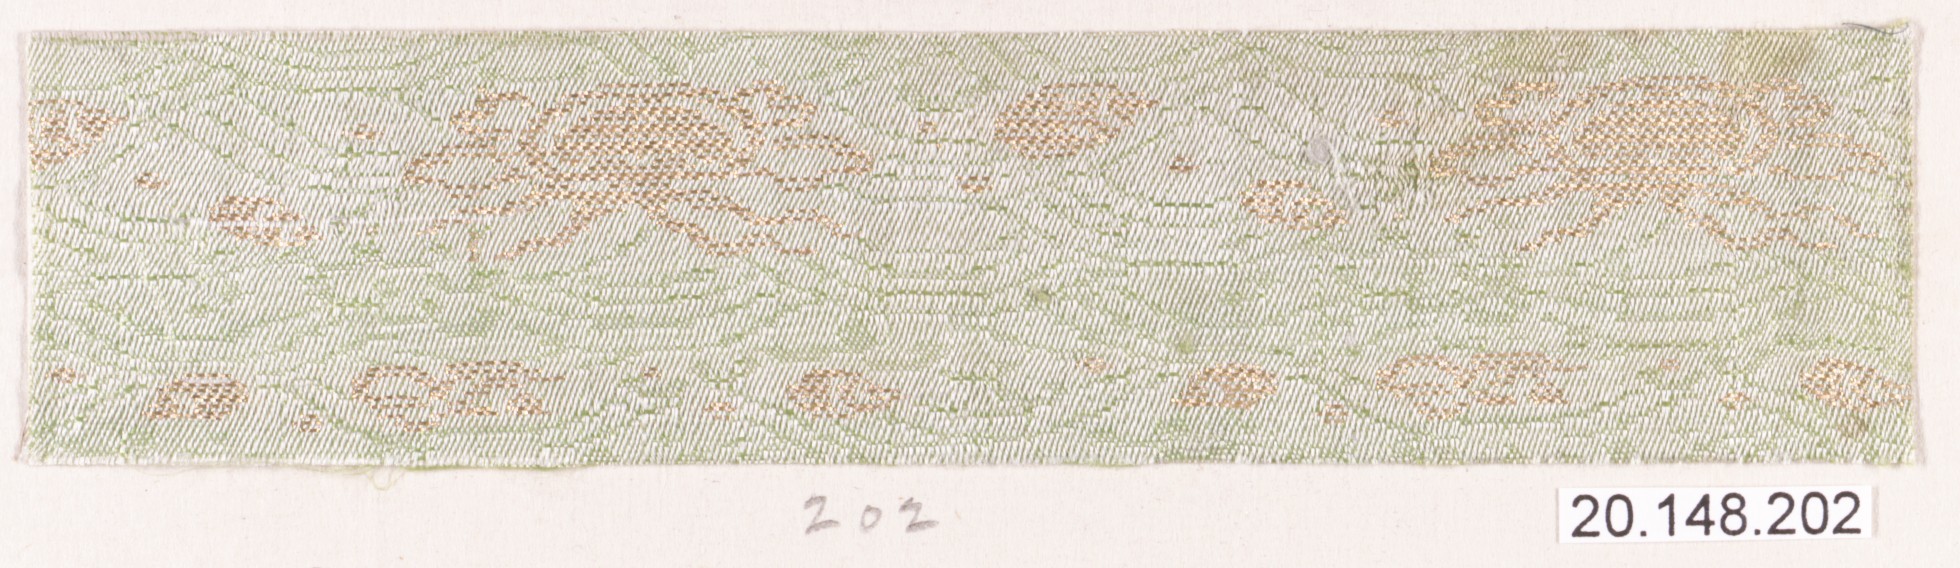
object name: piece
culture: japanese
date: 1701-1800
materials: silk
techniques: compound weave